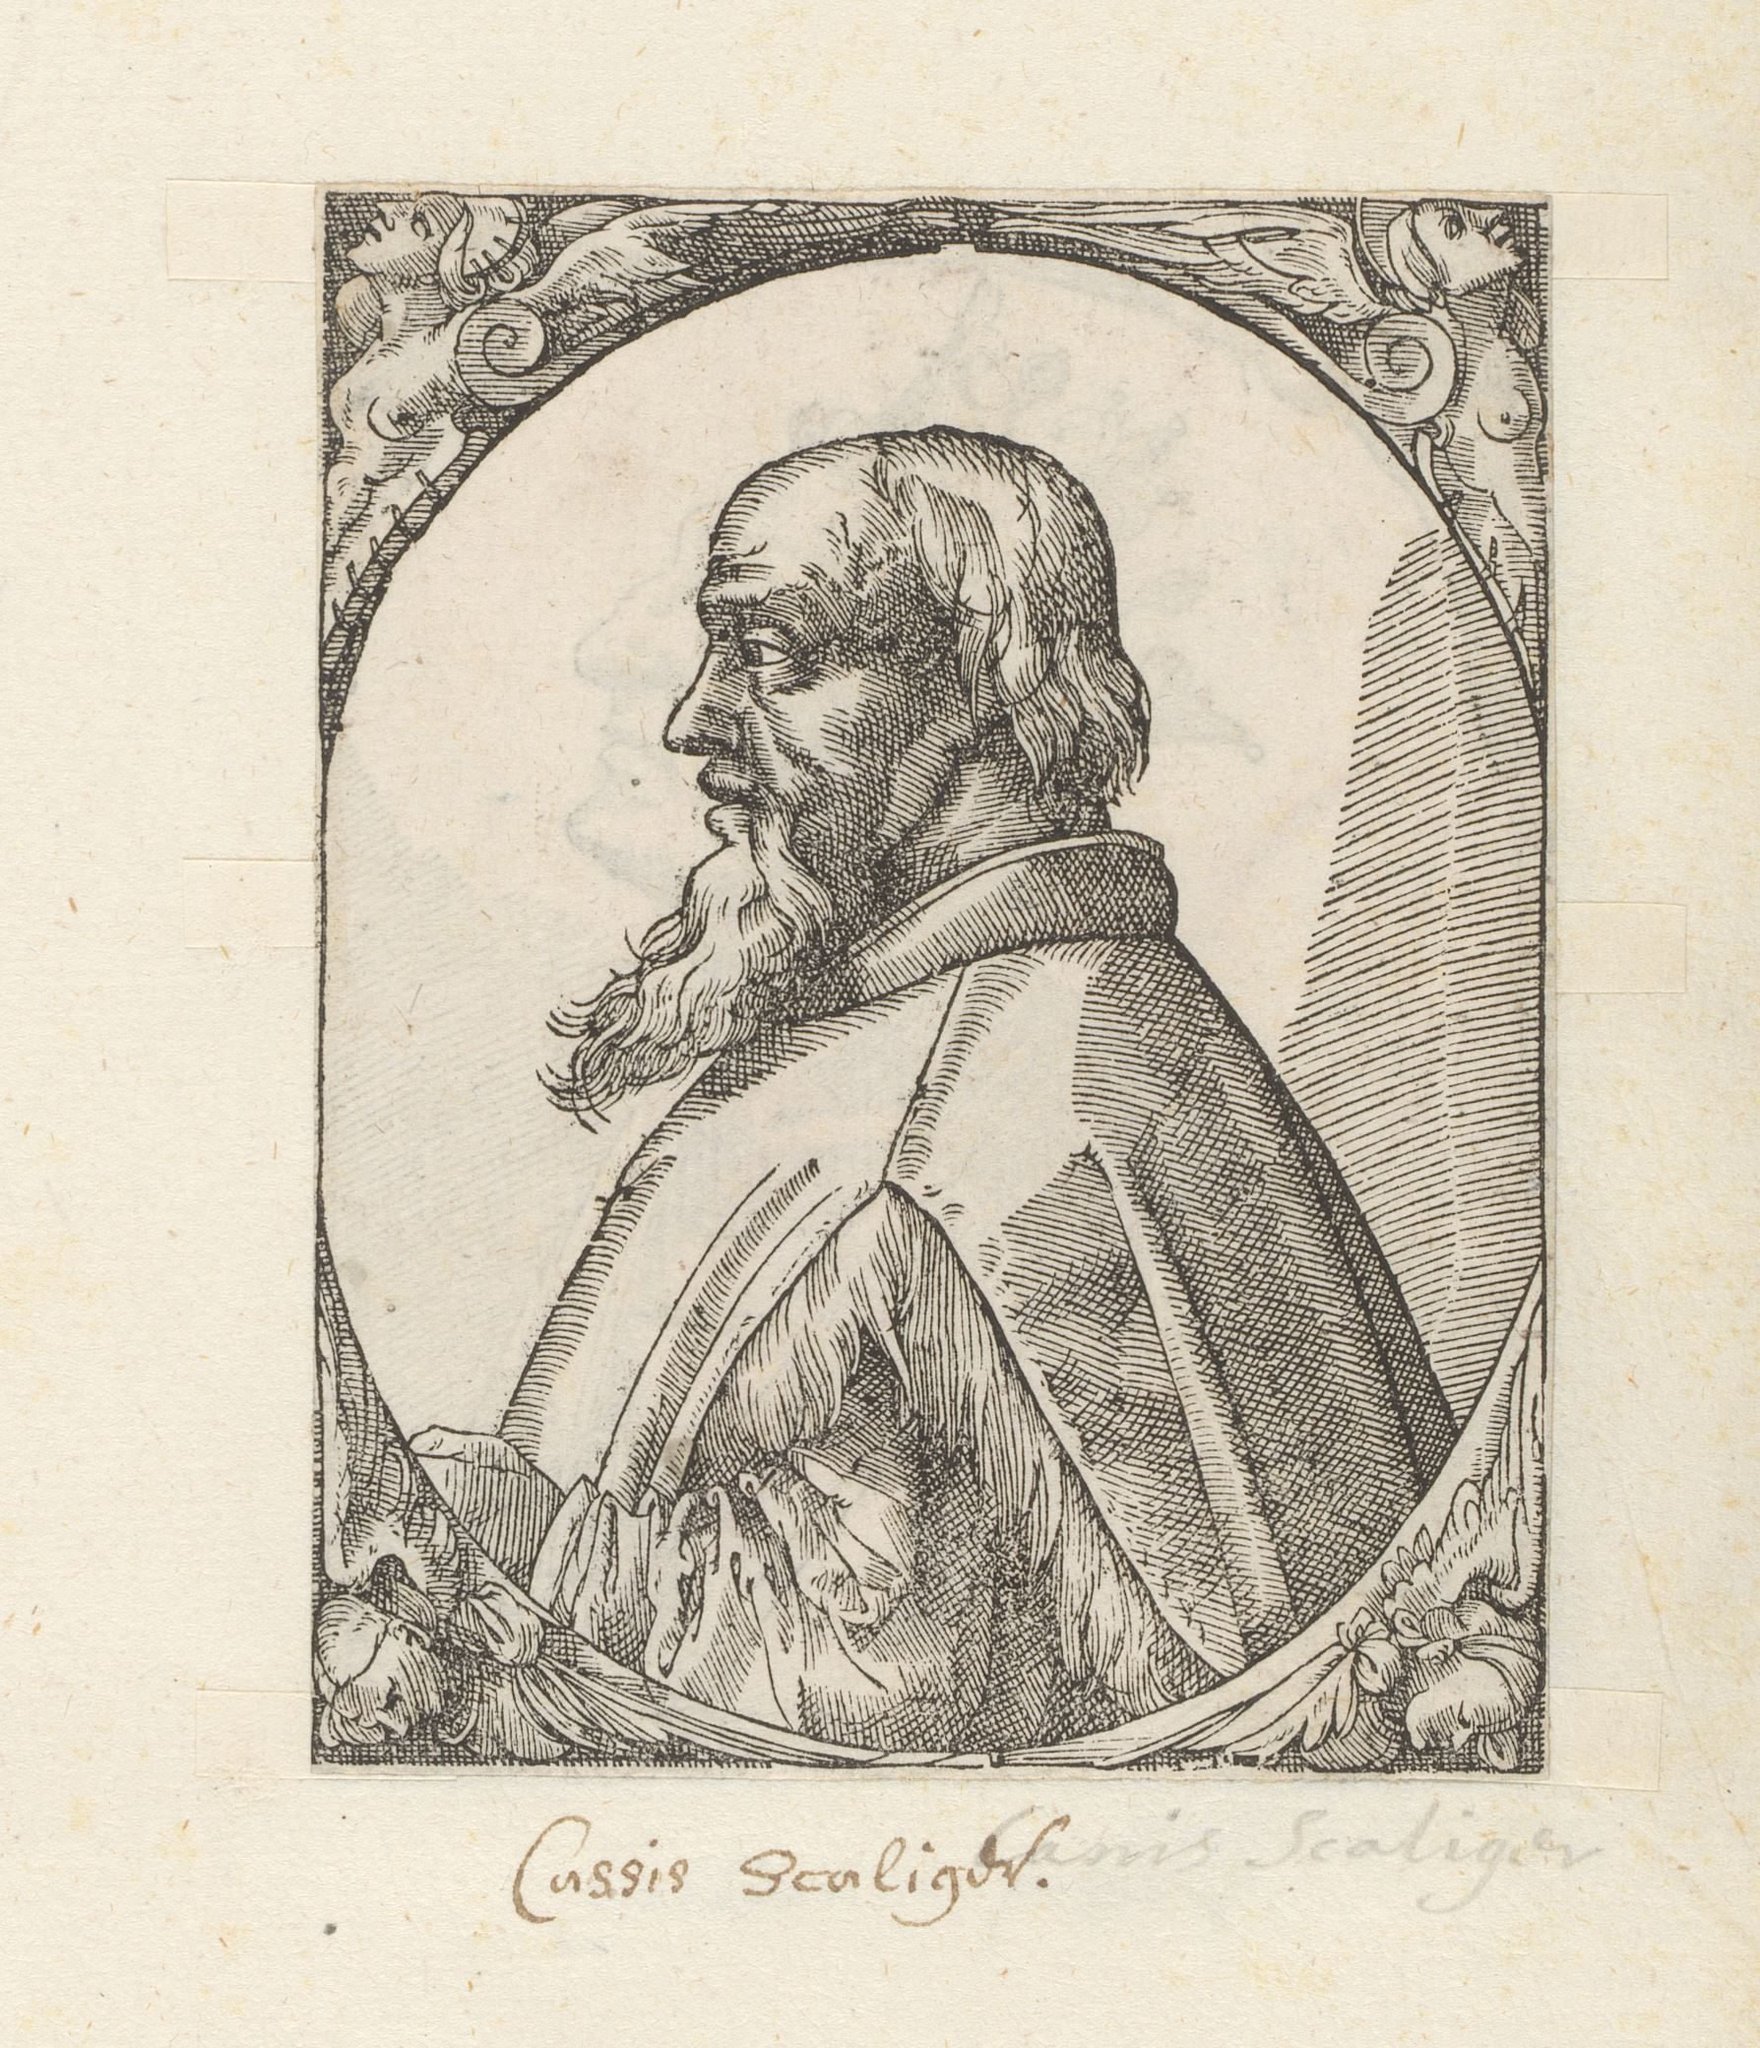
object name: album leaf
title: Portret van Canis Scaliger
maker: Anonymous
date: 1549-1575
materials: paper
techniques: woodcut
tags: historical persons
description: Prent gebruikt in: Giovio, Paolo. Elogia Virorum bellica virtute illustrium (...). Bazel: Peter Perna, 1575.